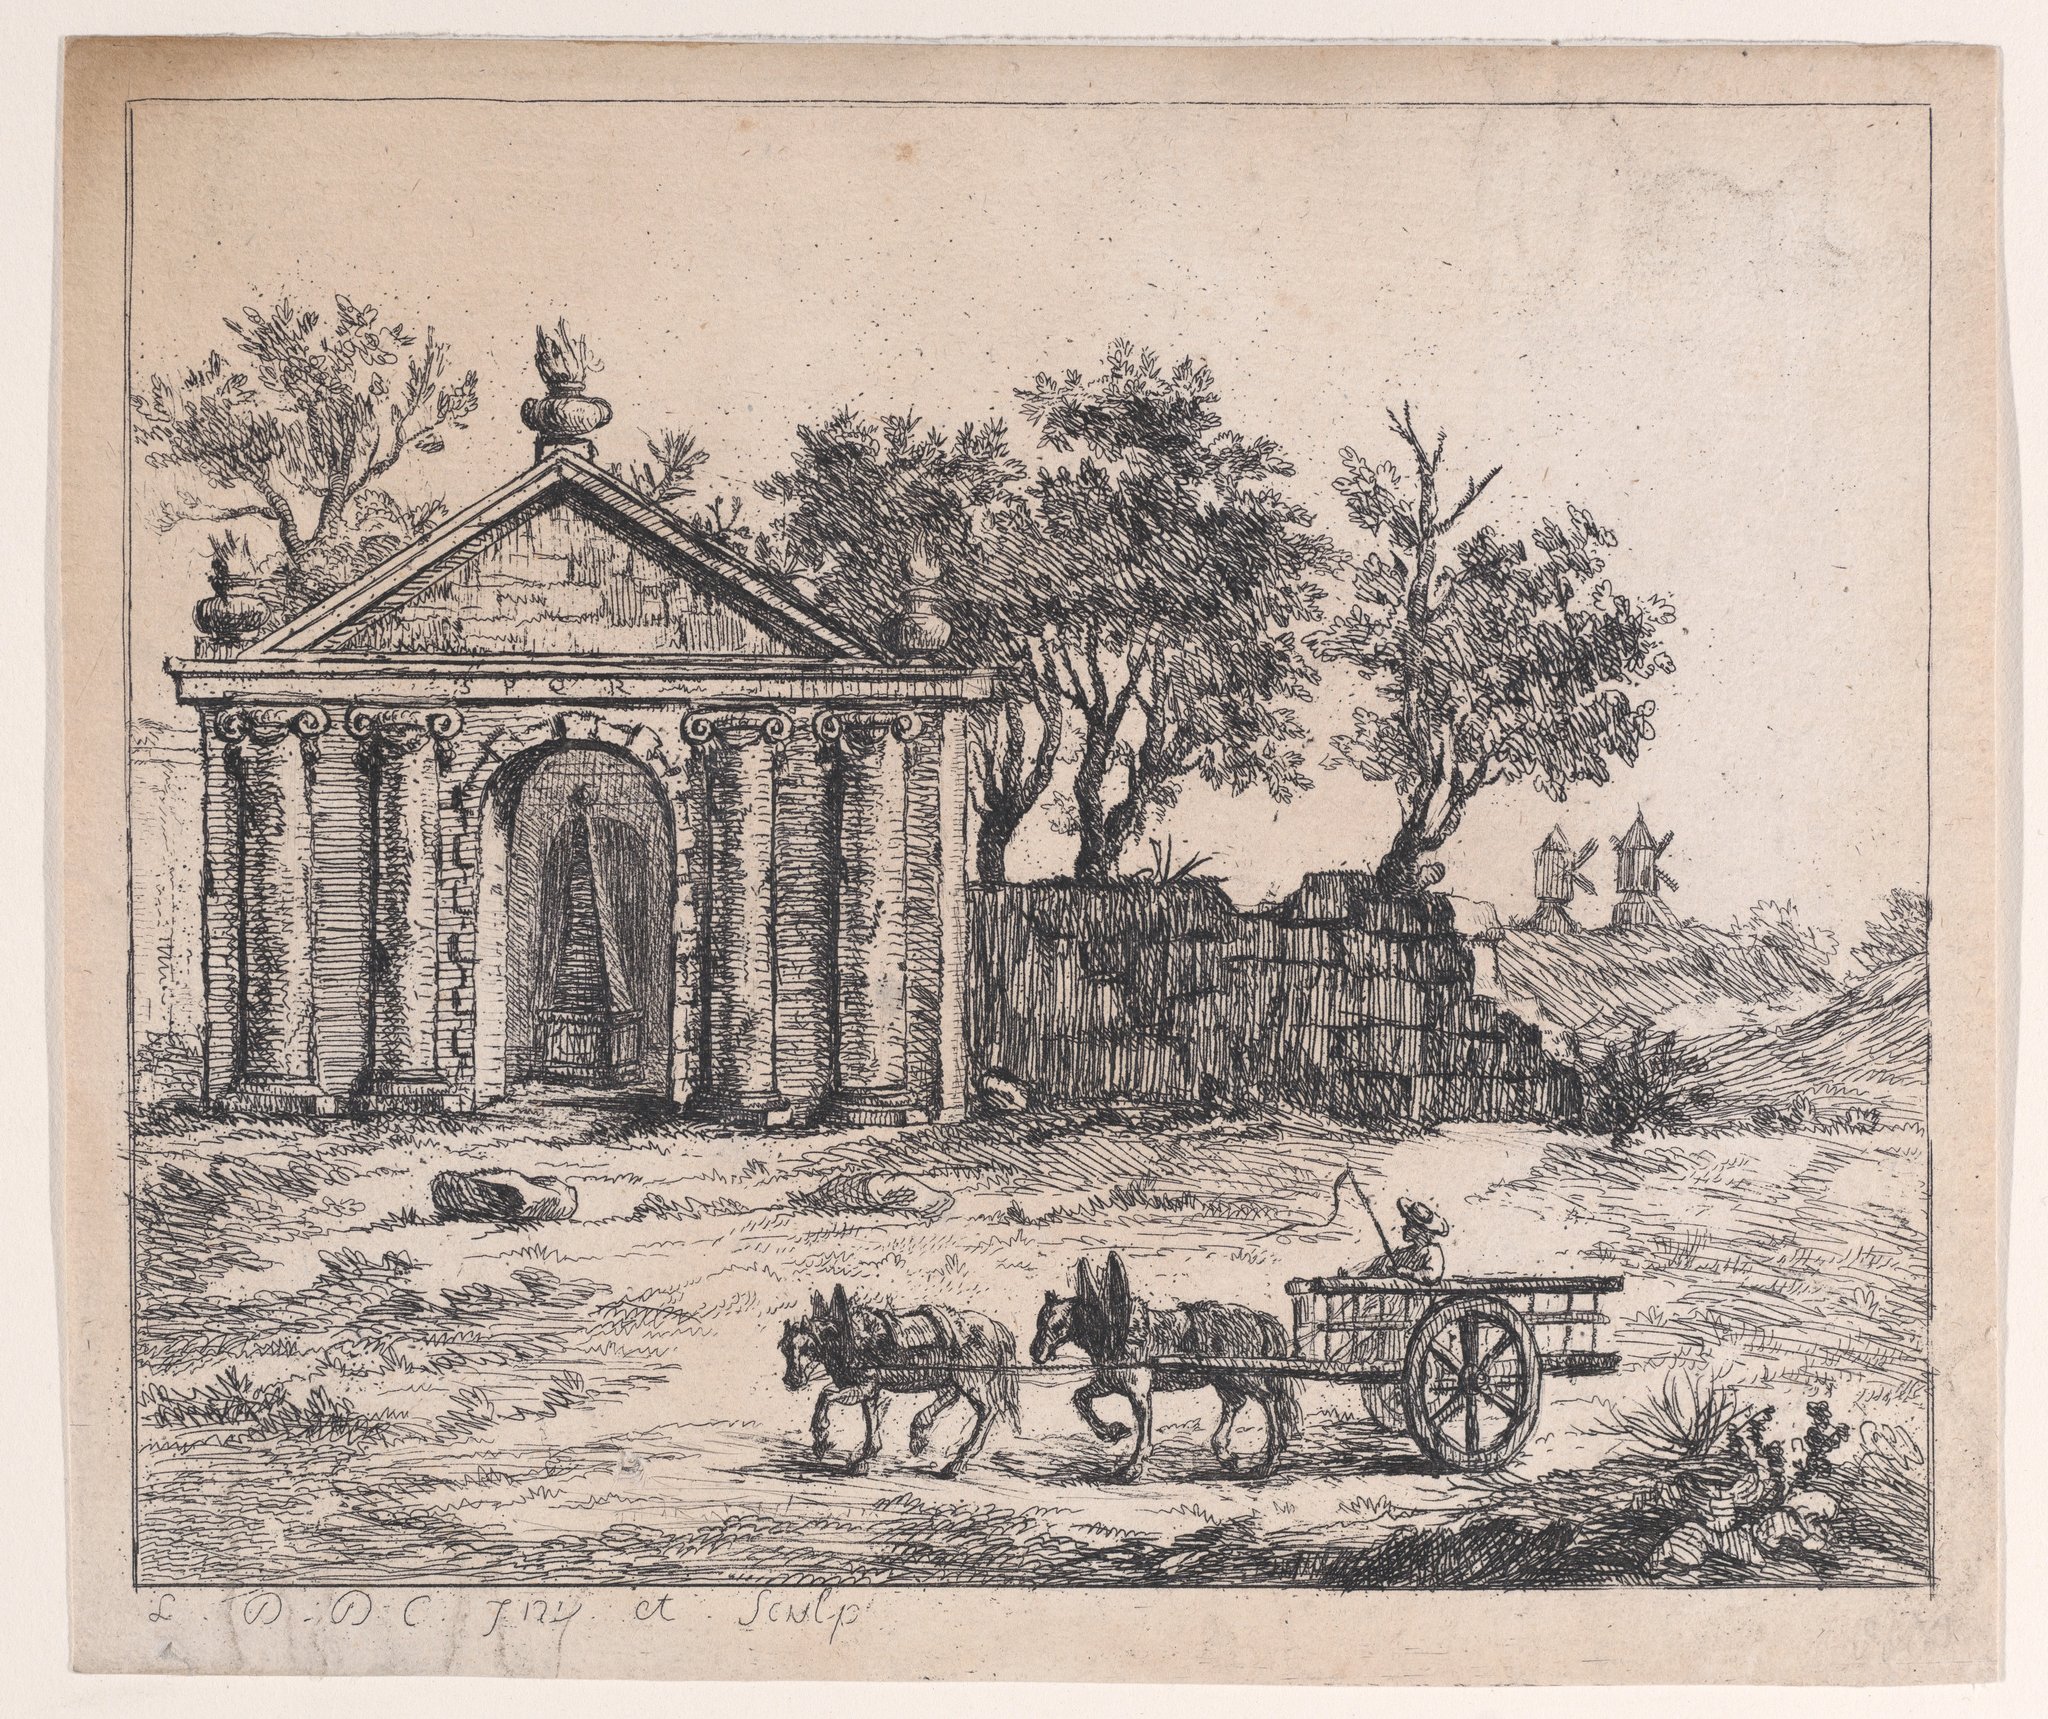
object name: print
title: Landscape with Roman Temple and Wagon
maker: louis philippe joseph, duc de chartres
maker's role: artist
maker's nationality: french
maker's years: 1726-1785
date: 1701-1800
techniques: etching